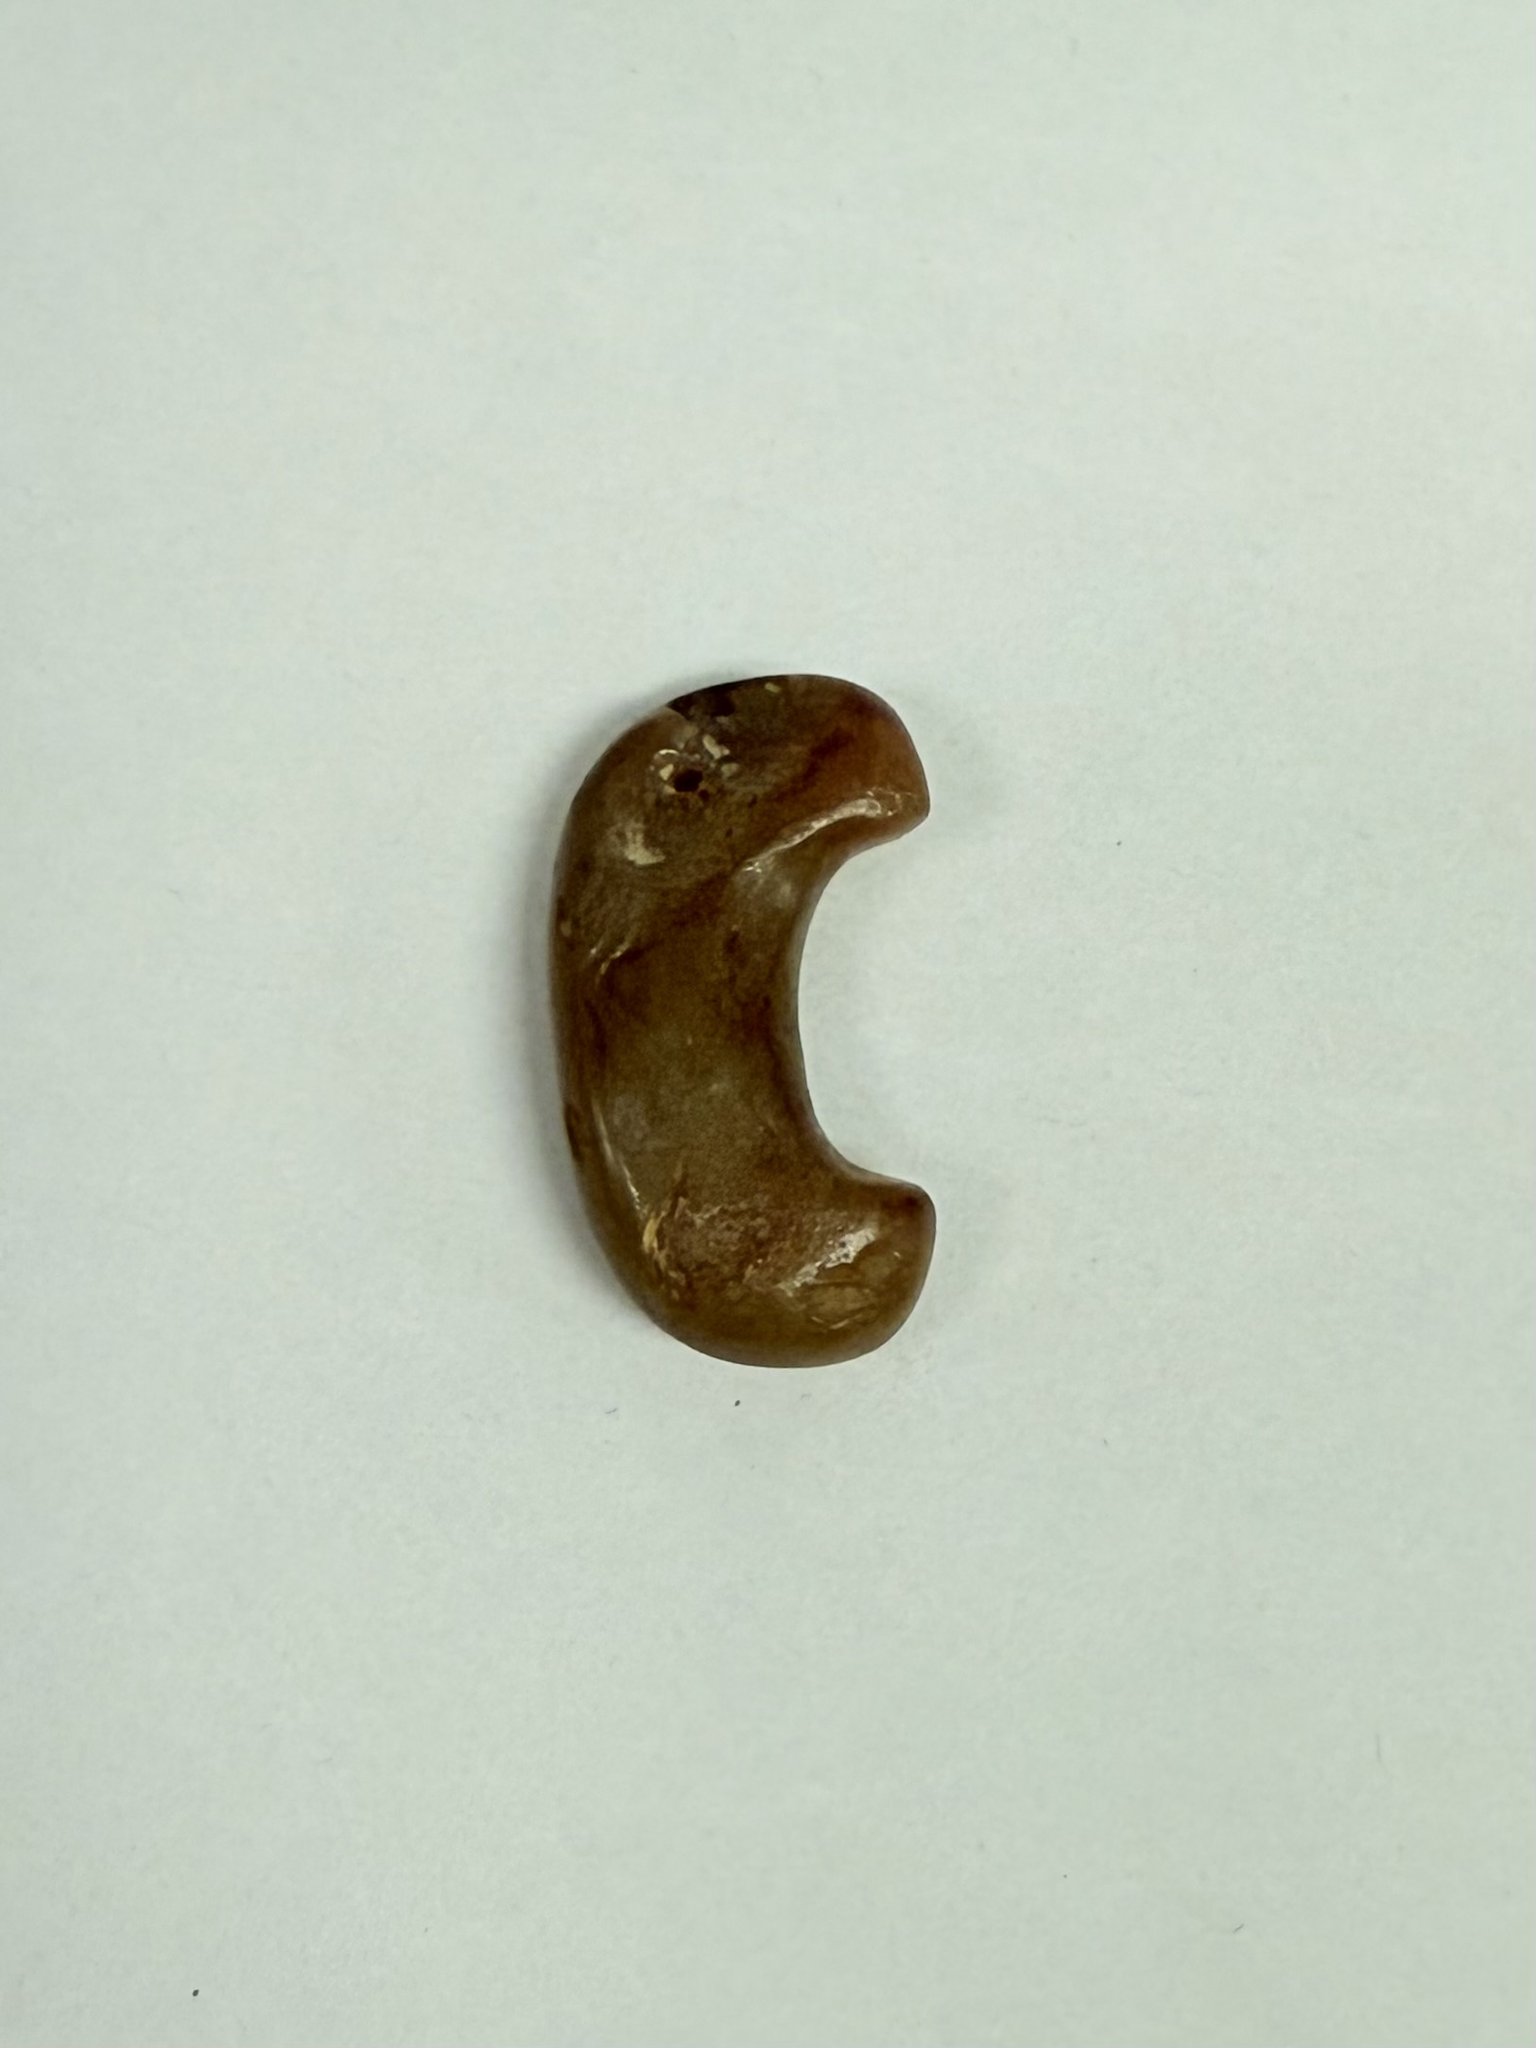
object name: jewel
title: Tiger Claw Jewel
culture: japanese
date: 601-700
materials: stone, jade, jasper